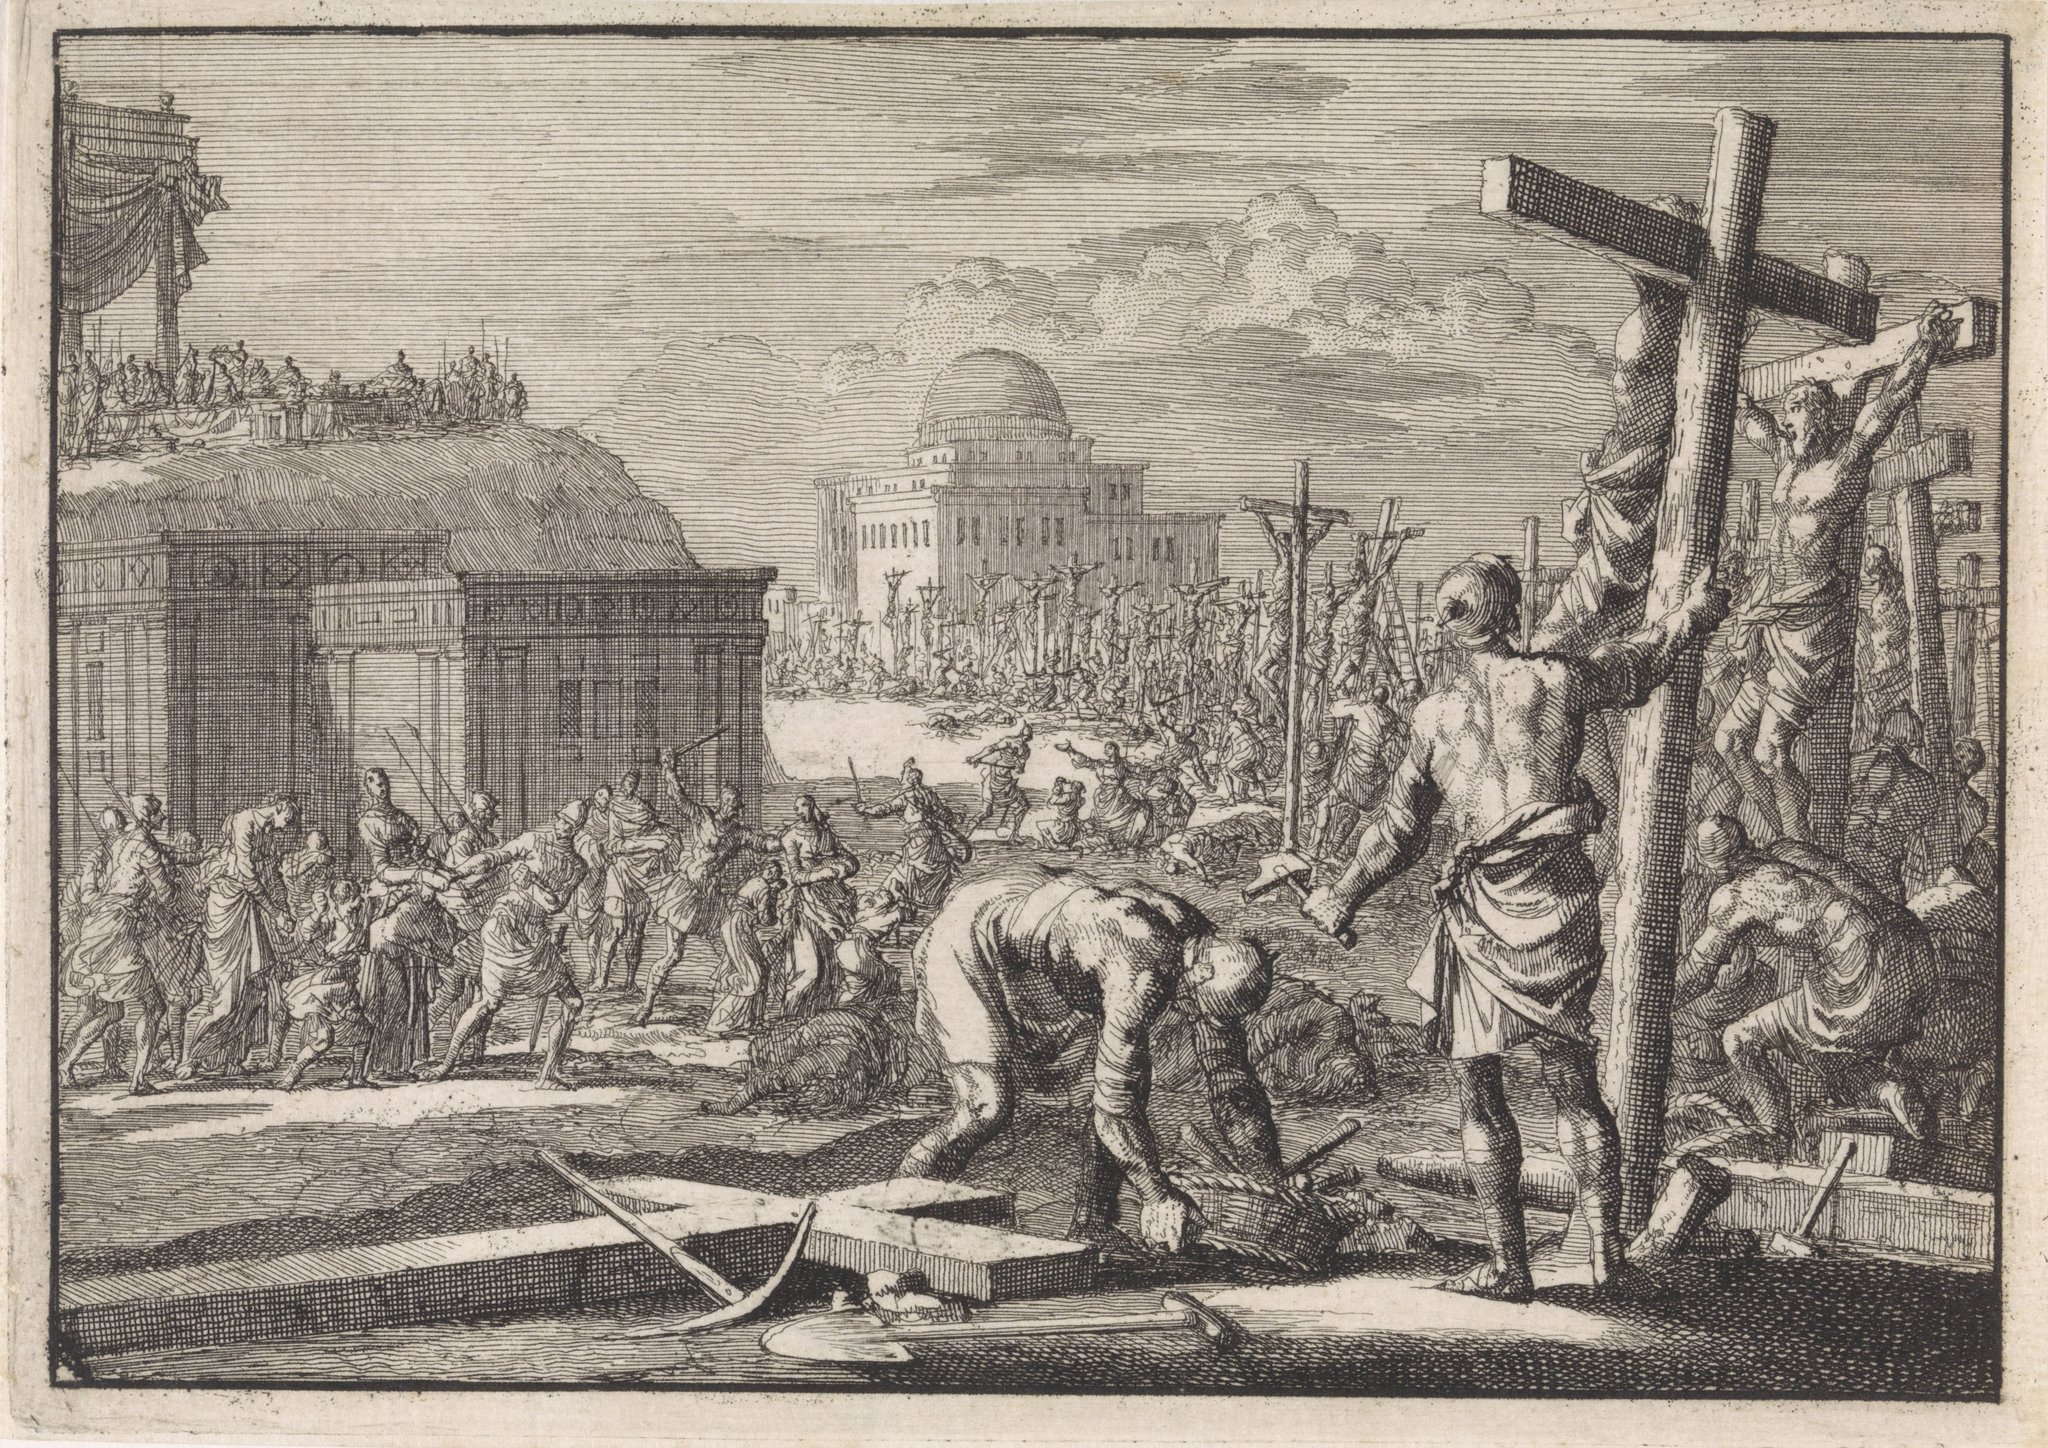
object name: print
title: Alexander Joannes, vorst der Joden, laat tegen hem gekante onderdanen kruisigen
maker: jan luyken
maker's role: draughtsman, print maker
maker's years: 1649-1712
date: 1704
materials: paper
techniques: etching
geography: amsterdam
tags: violent death by crucifixion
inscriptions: collector's mark: Lugt 2228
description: Prent ook gebruikt als boekillustratie in: Josephus, Flavius. Alle de Werken, 2 delen. Amsterdam: Pieter Mortier, 1704, dl. 1, p. 329.